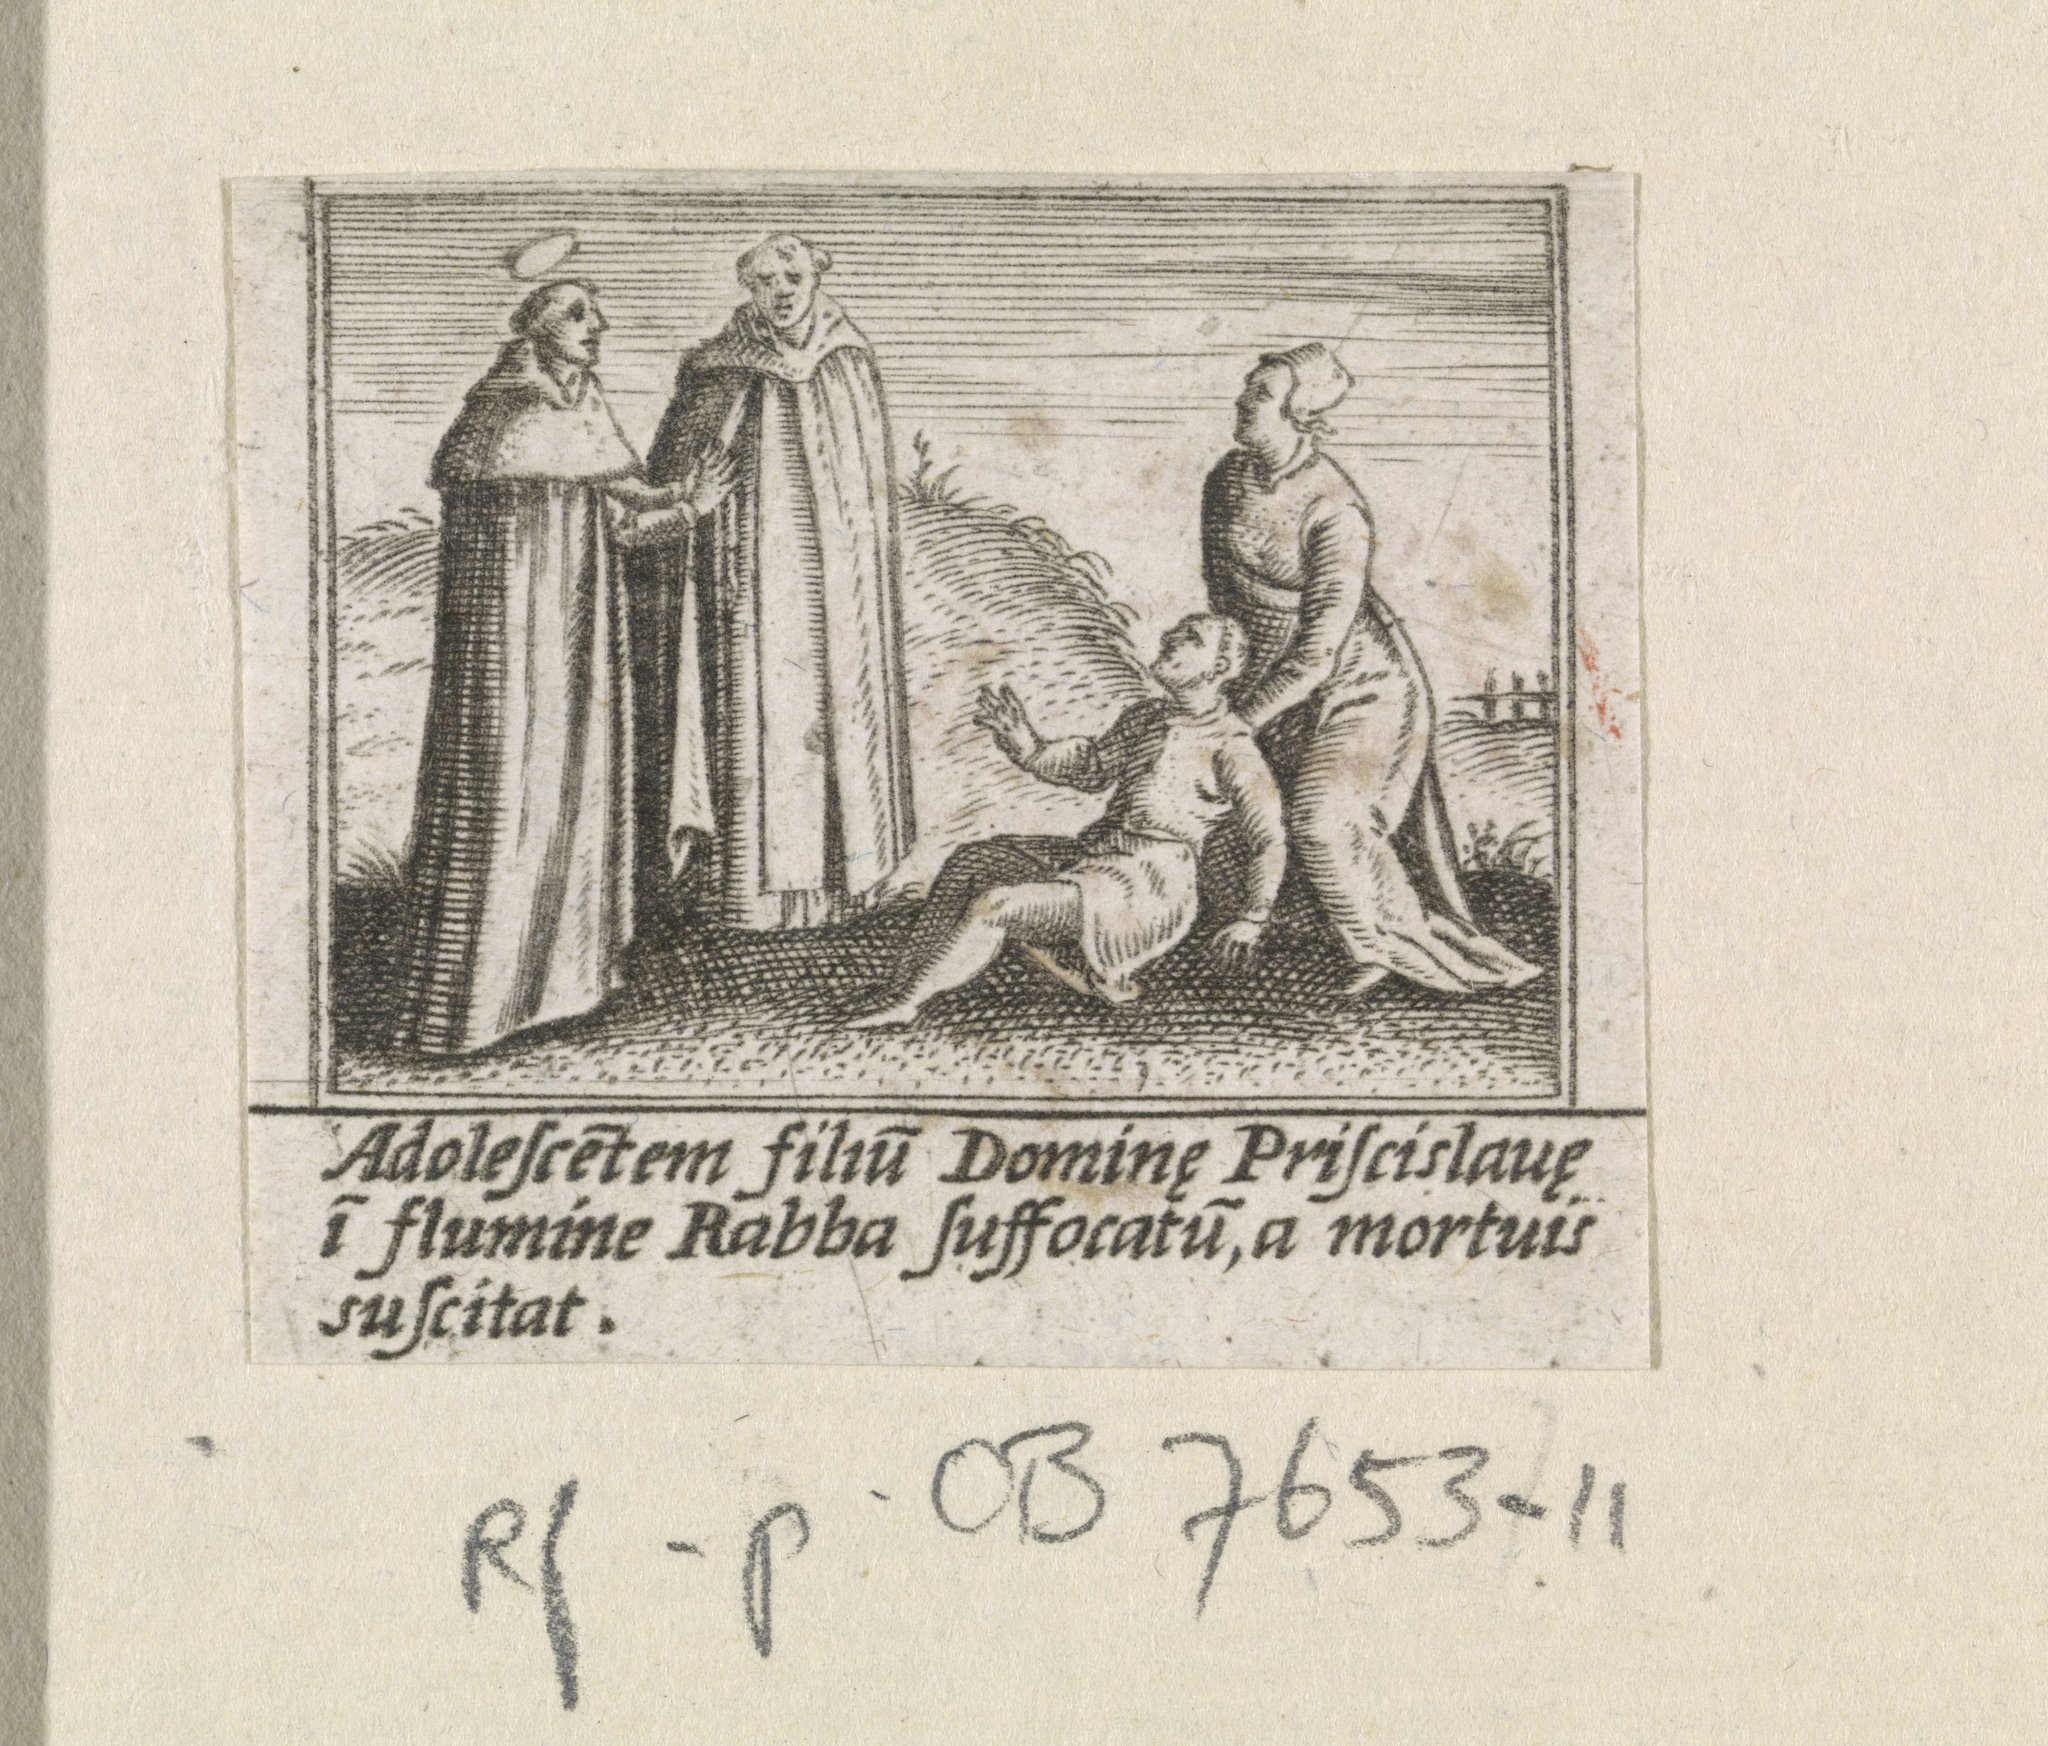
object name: print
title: Heilige Hyacinthus van Polen ontmoet een liggende man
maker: johann sadeler (i)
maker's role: print maker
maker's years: 1550-1600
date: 1595-1600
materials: paper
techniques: engraving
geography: venice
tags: monk(s), friar(s), the dominican friar hyacinth(us) of poland; possible attributes: book, lily, monstrance (or ciborium), statue of the virgin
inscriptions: collector's mark: Lugt 240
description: De H. Hyacinthus van Polen en een monnik staan voor vrouw en een liggende man. De prent maakt deel uit van een achttiendelige serie die een kader vormt rondom een afbeelding van de H. Hyacinthus van Polen.